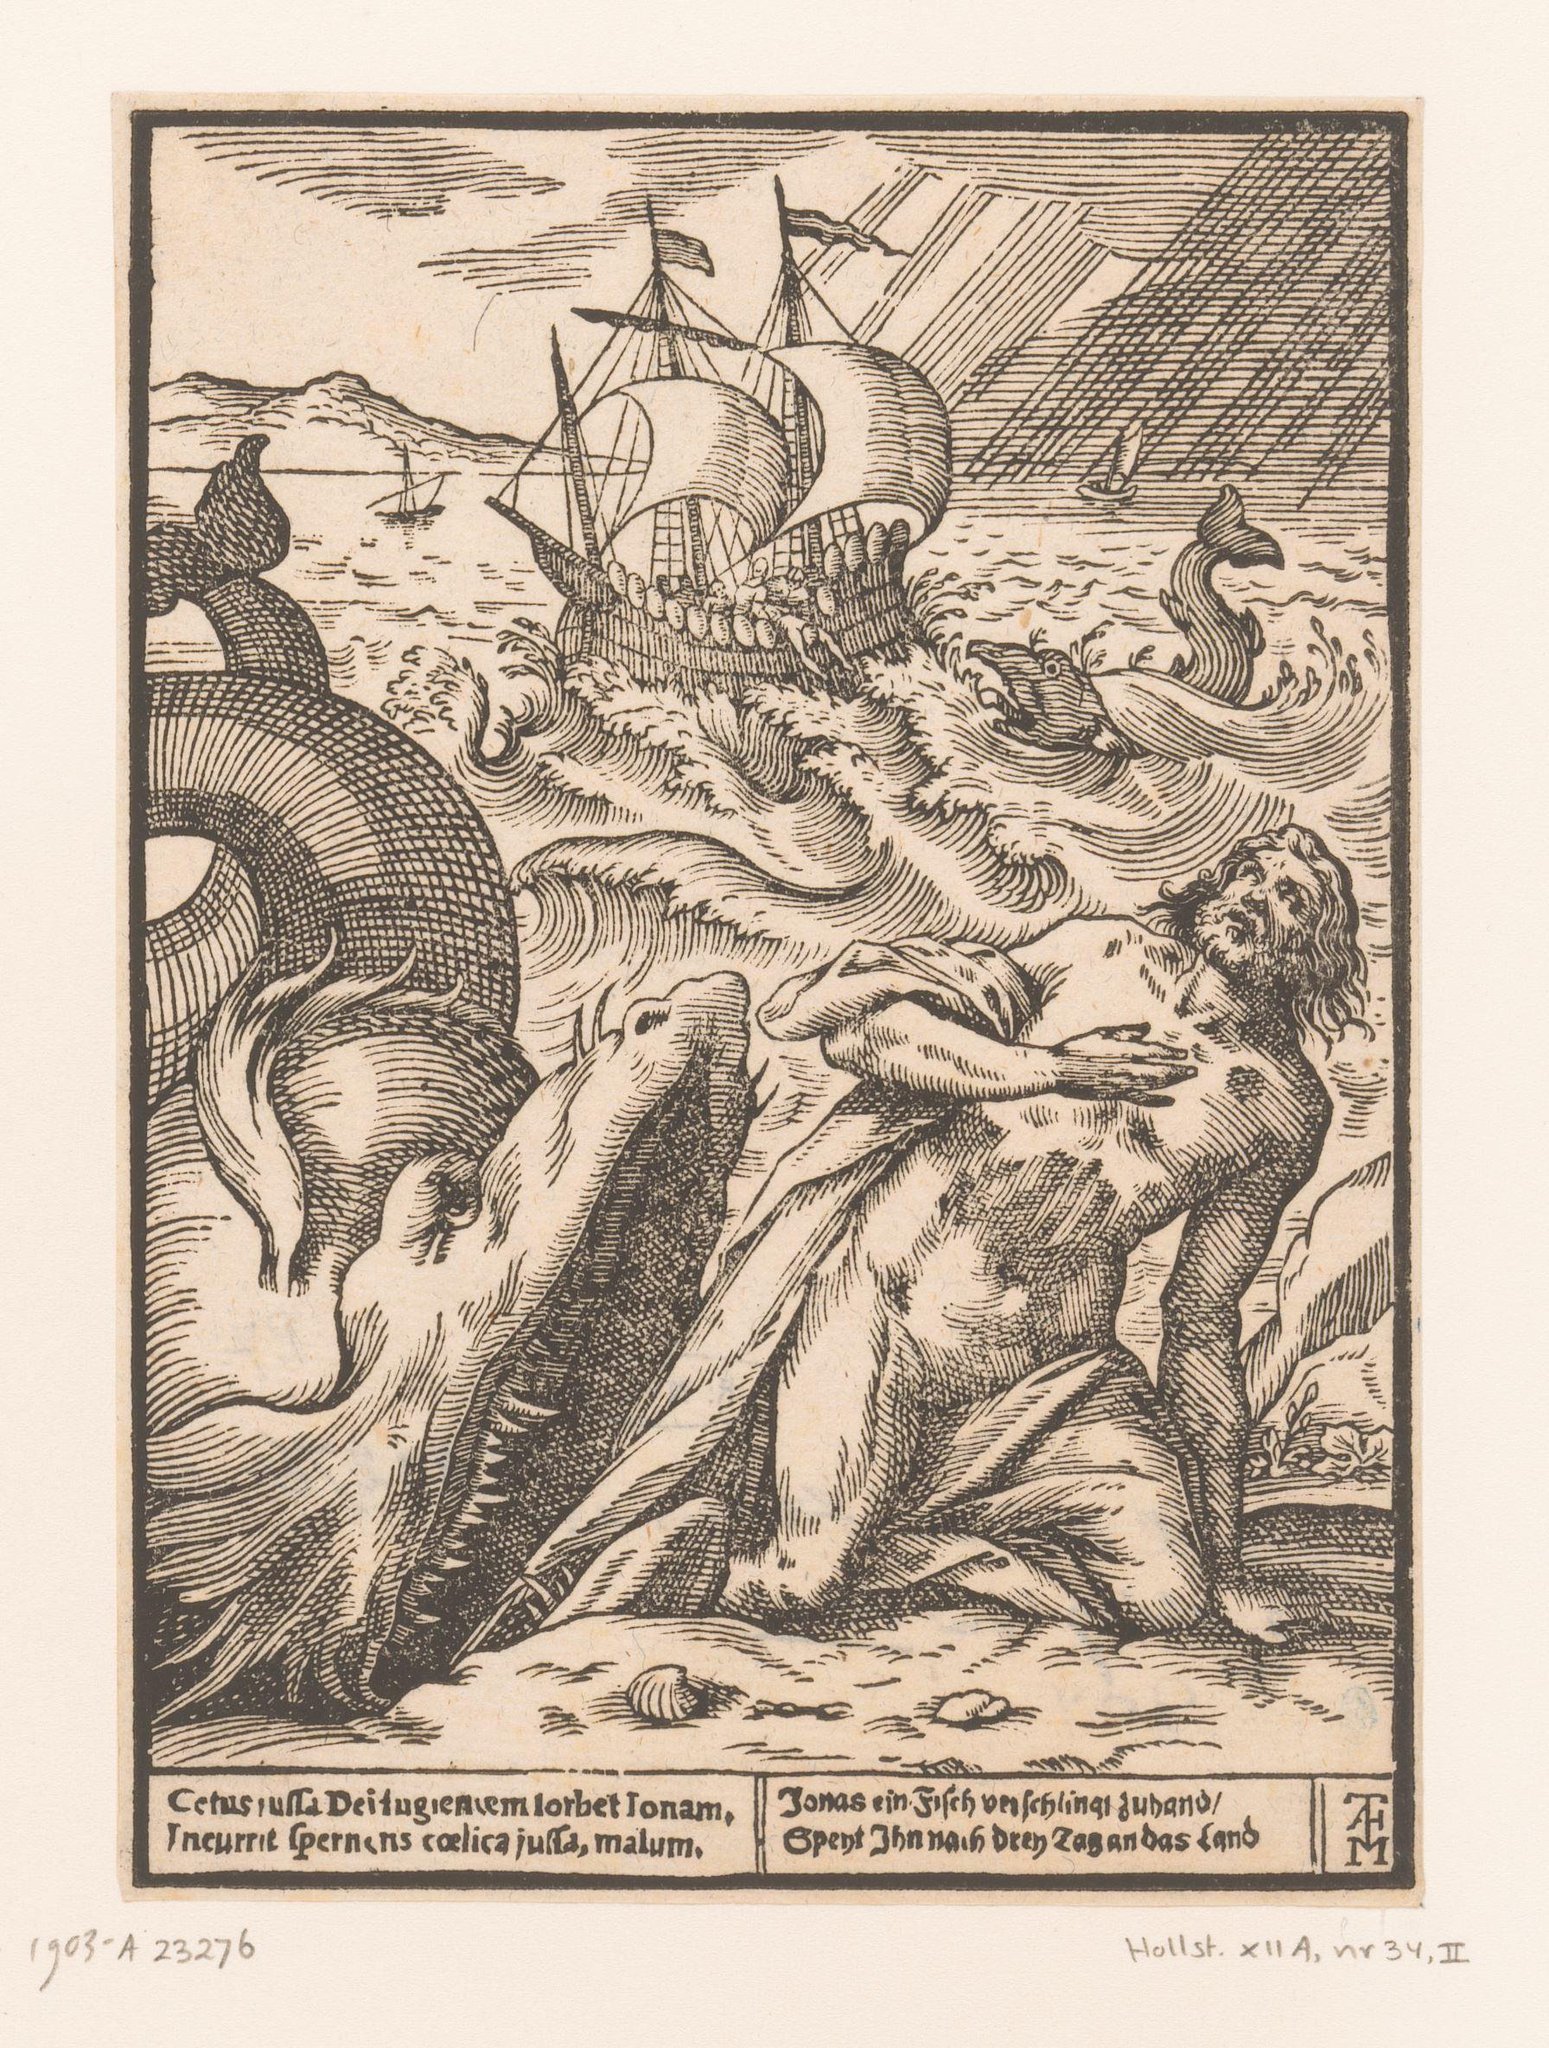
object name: print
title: Leven van Christus, evangeslisten en heiligen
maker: marx anton hannas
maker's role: print maker, publisher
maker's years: 1600-1676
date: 1610-1676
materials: paper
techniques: woodcut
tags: after a three-day sojourn in the belly of the monster jonah is cast on dry land; jonah may be shown nude and bald-headed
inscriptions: collector's mark: Lugt 2228